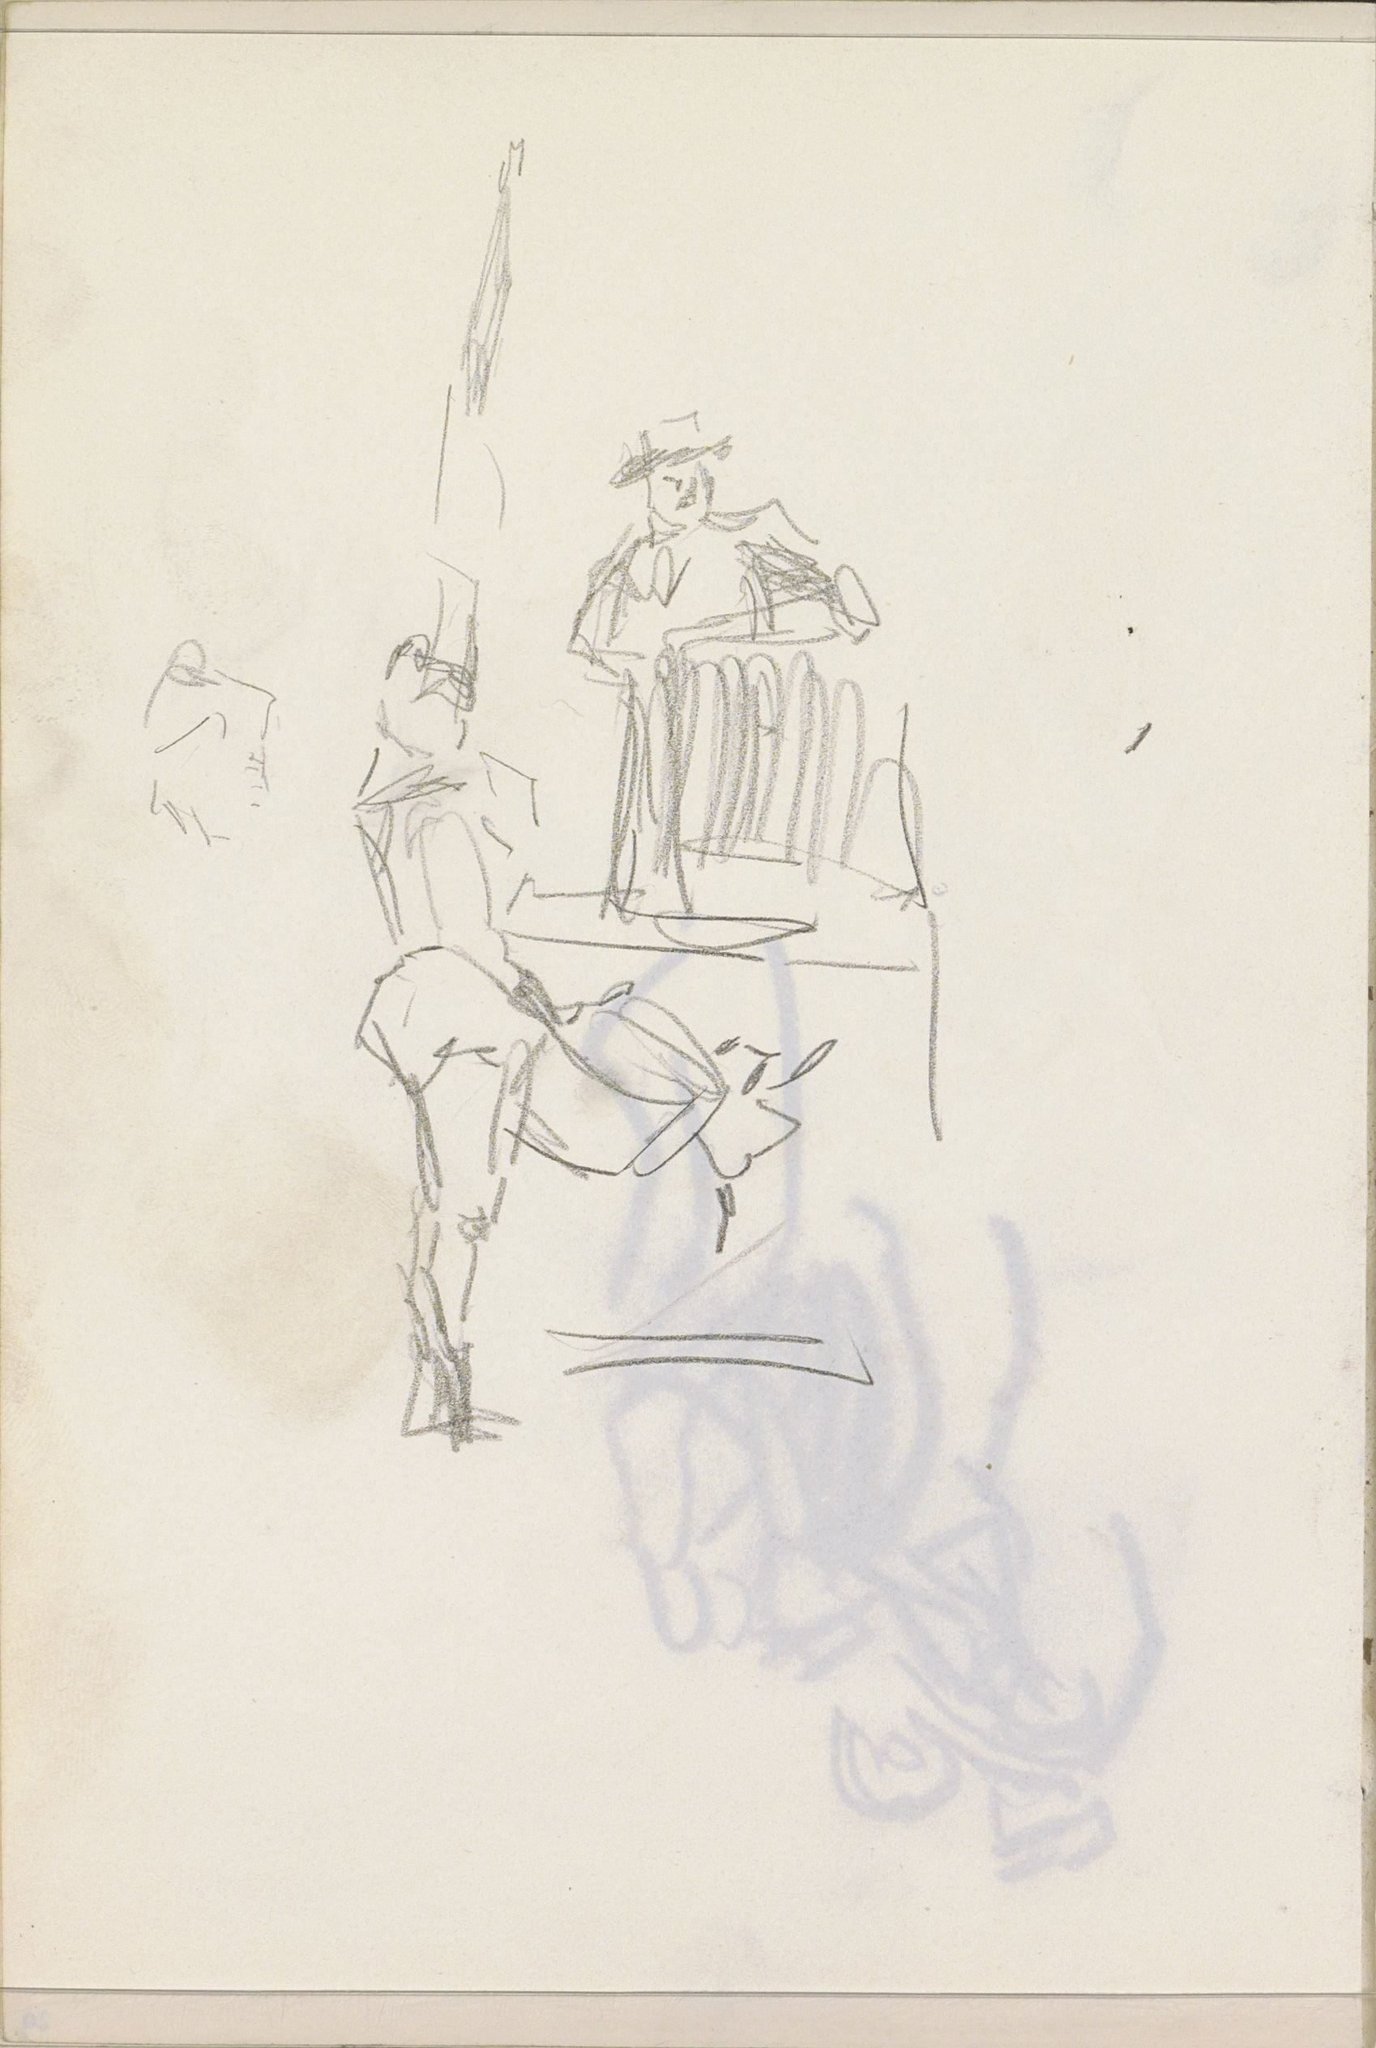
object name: sketchbook leaf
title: Trommelaar voor een zittende man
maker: isaac israels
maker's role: draughtsman, painter, print maker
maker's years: 1865-1934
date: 1875-1934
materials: paper, pencil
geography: paris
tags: adult man (+ sitting), musician, drum (musical instrument)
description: Blad 29 verso uit schetsboek L met 42 bladen.